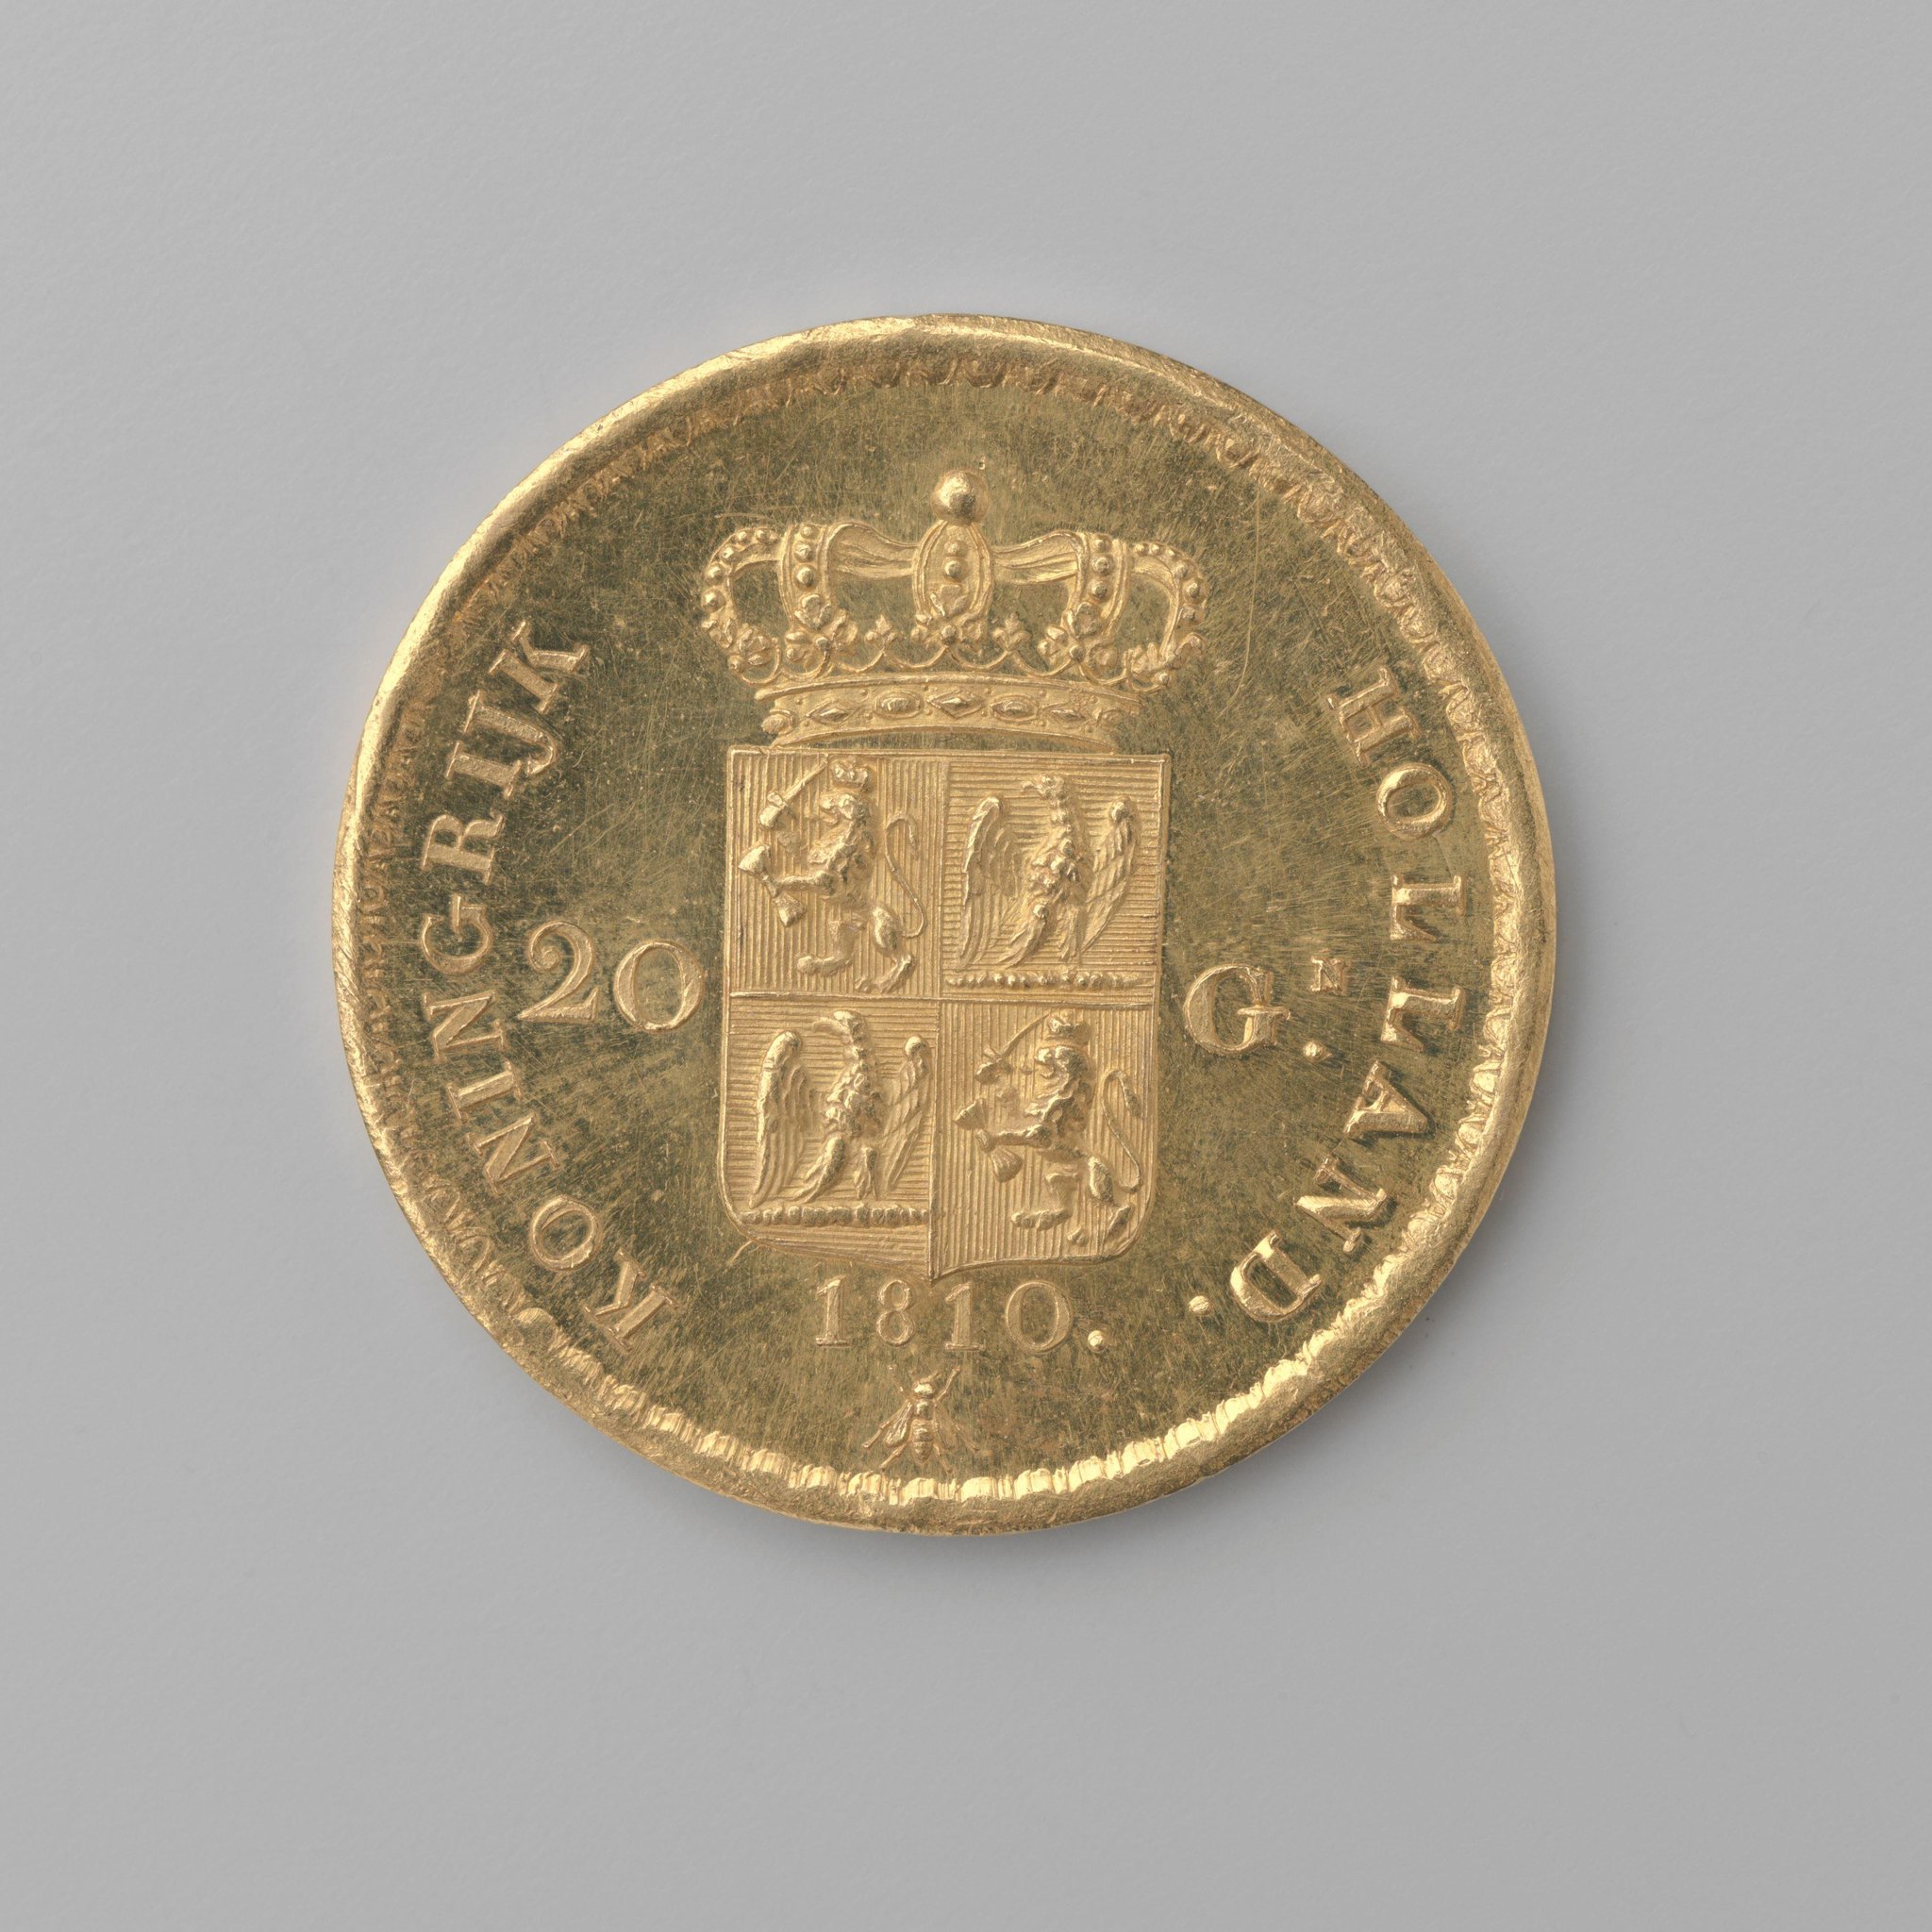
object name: twintig gulden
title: Koninkrijk Holland, 20 gulden, 1810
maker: louis napoleon (king of holland)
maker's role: koning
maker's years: 1778-1846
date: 1810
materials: gold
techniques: striking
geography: utrecht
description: Gouden munt. Voorzijde: borstbeeld van de koning naar links. Keerzijde: tussen waarde-aanduiding 20 Gn. gekroond wapenschild, waaronder jaartal. Daaronder muntmeesterteken bij. Randschrift.